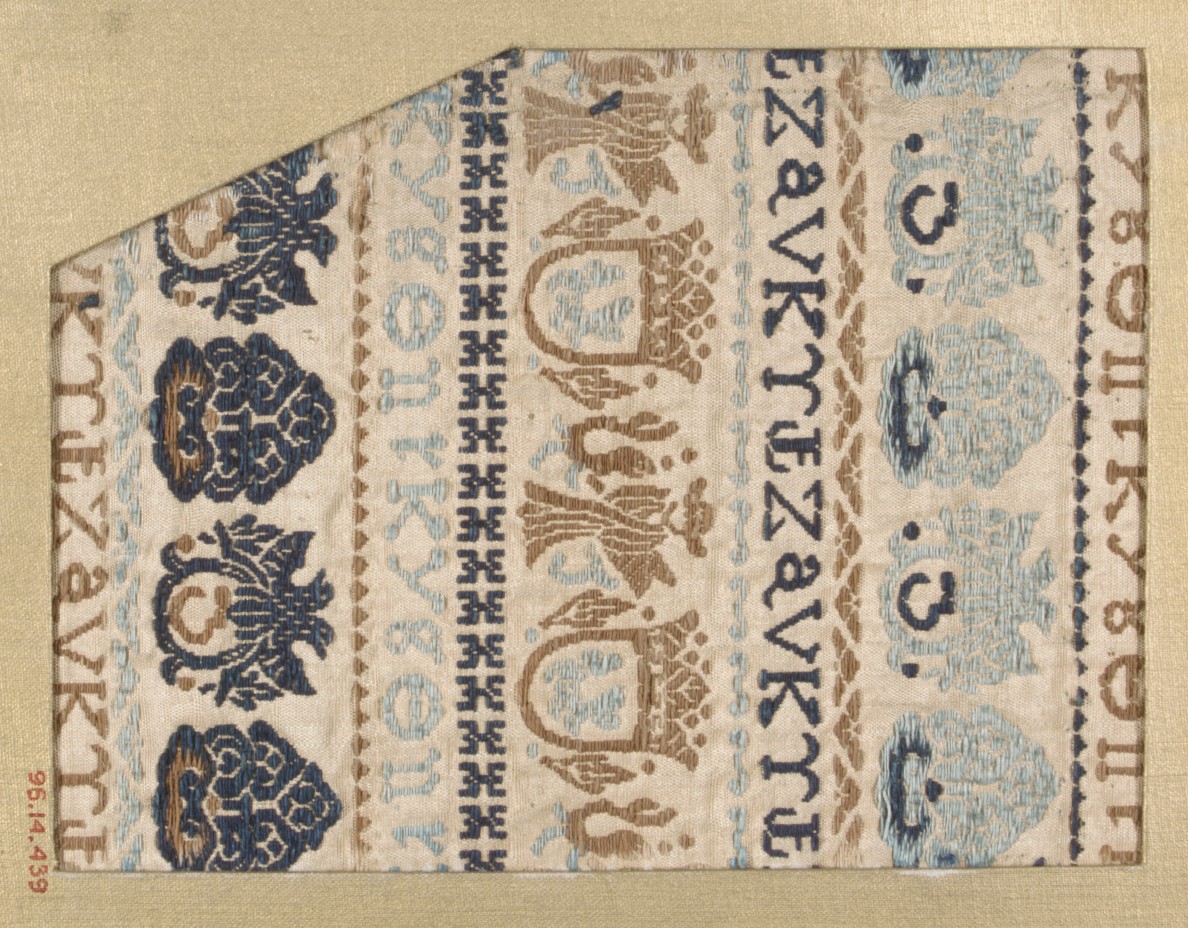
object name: piece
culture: japanese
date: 1701-1900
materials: silk